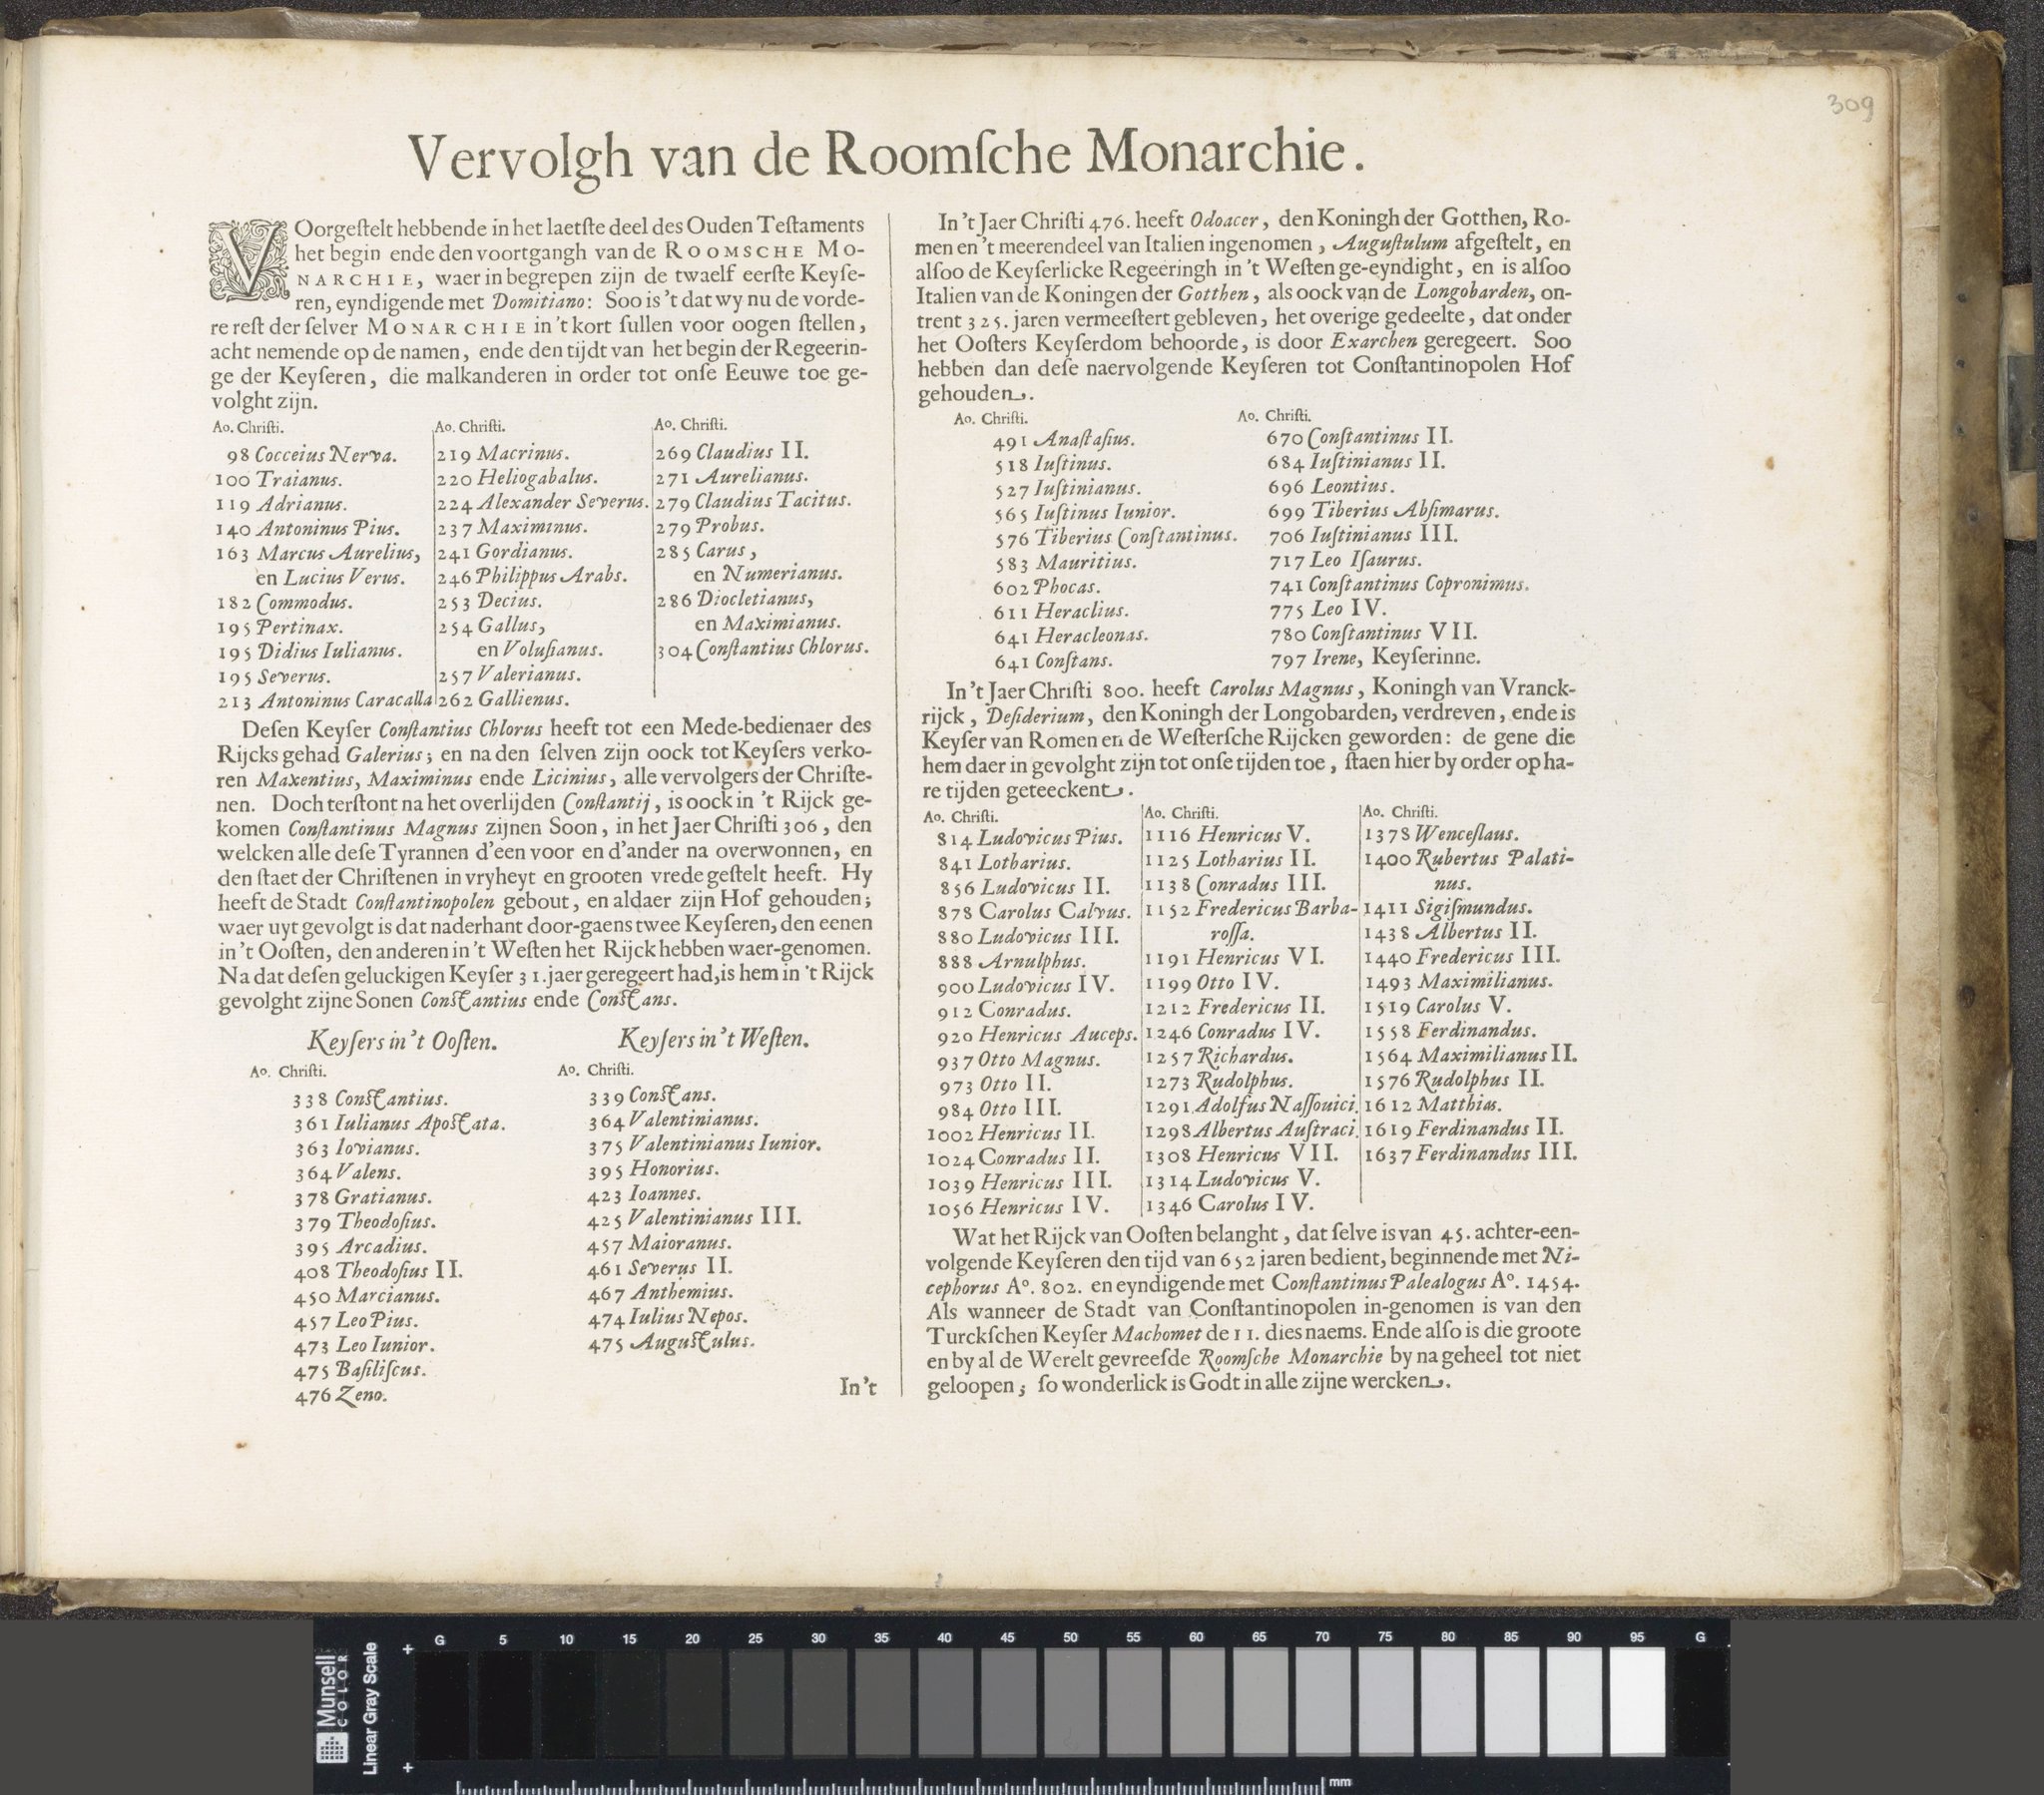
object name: album leaf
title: Den Grooten Emblemata Sacra, bestaande in meer dan vier hondert bybelsche figuren, zoo des Ouden als des Nieuwen Testaments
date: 1653-1654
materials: paper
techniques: letterpress printing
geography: amsterdam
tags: initial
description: Inleiding op de latere keizers van het Heilige Roomse Rijk. De tekst vangt aan met een kleine gedecoreerde initiaal V. Het blad maakt deel uit van een album.